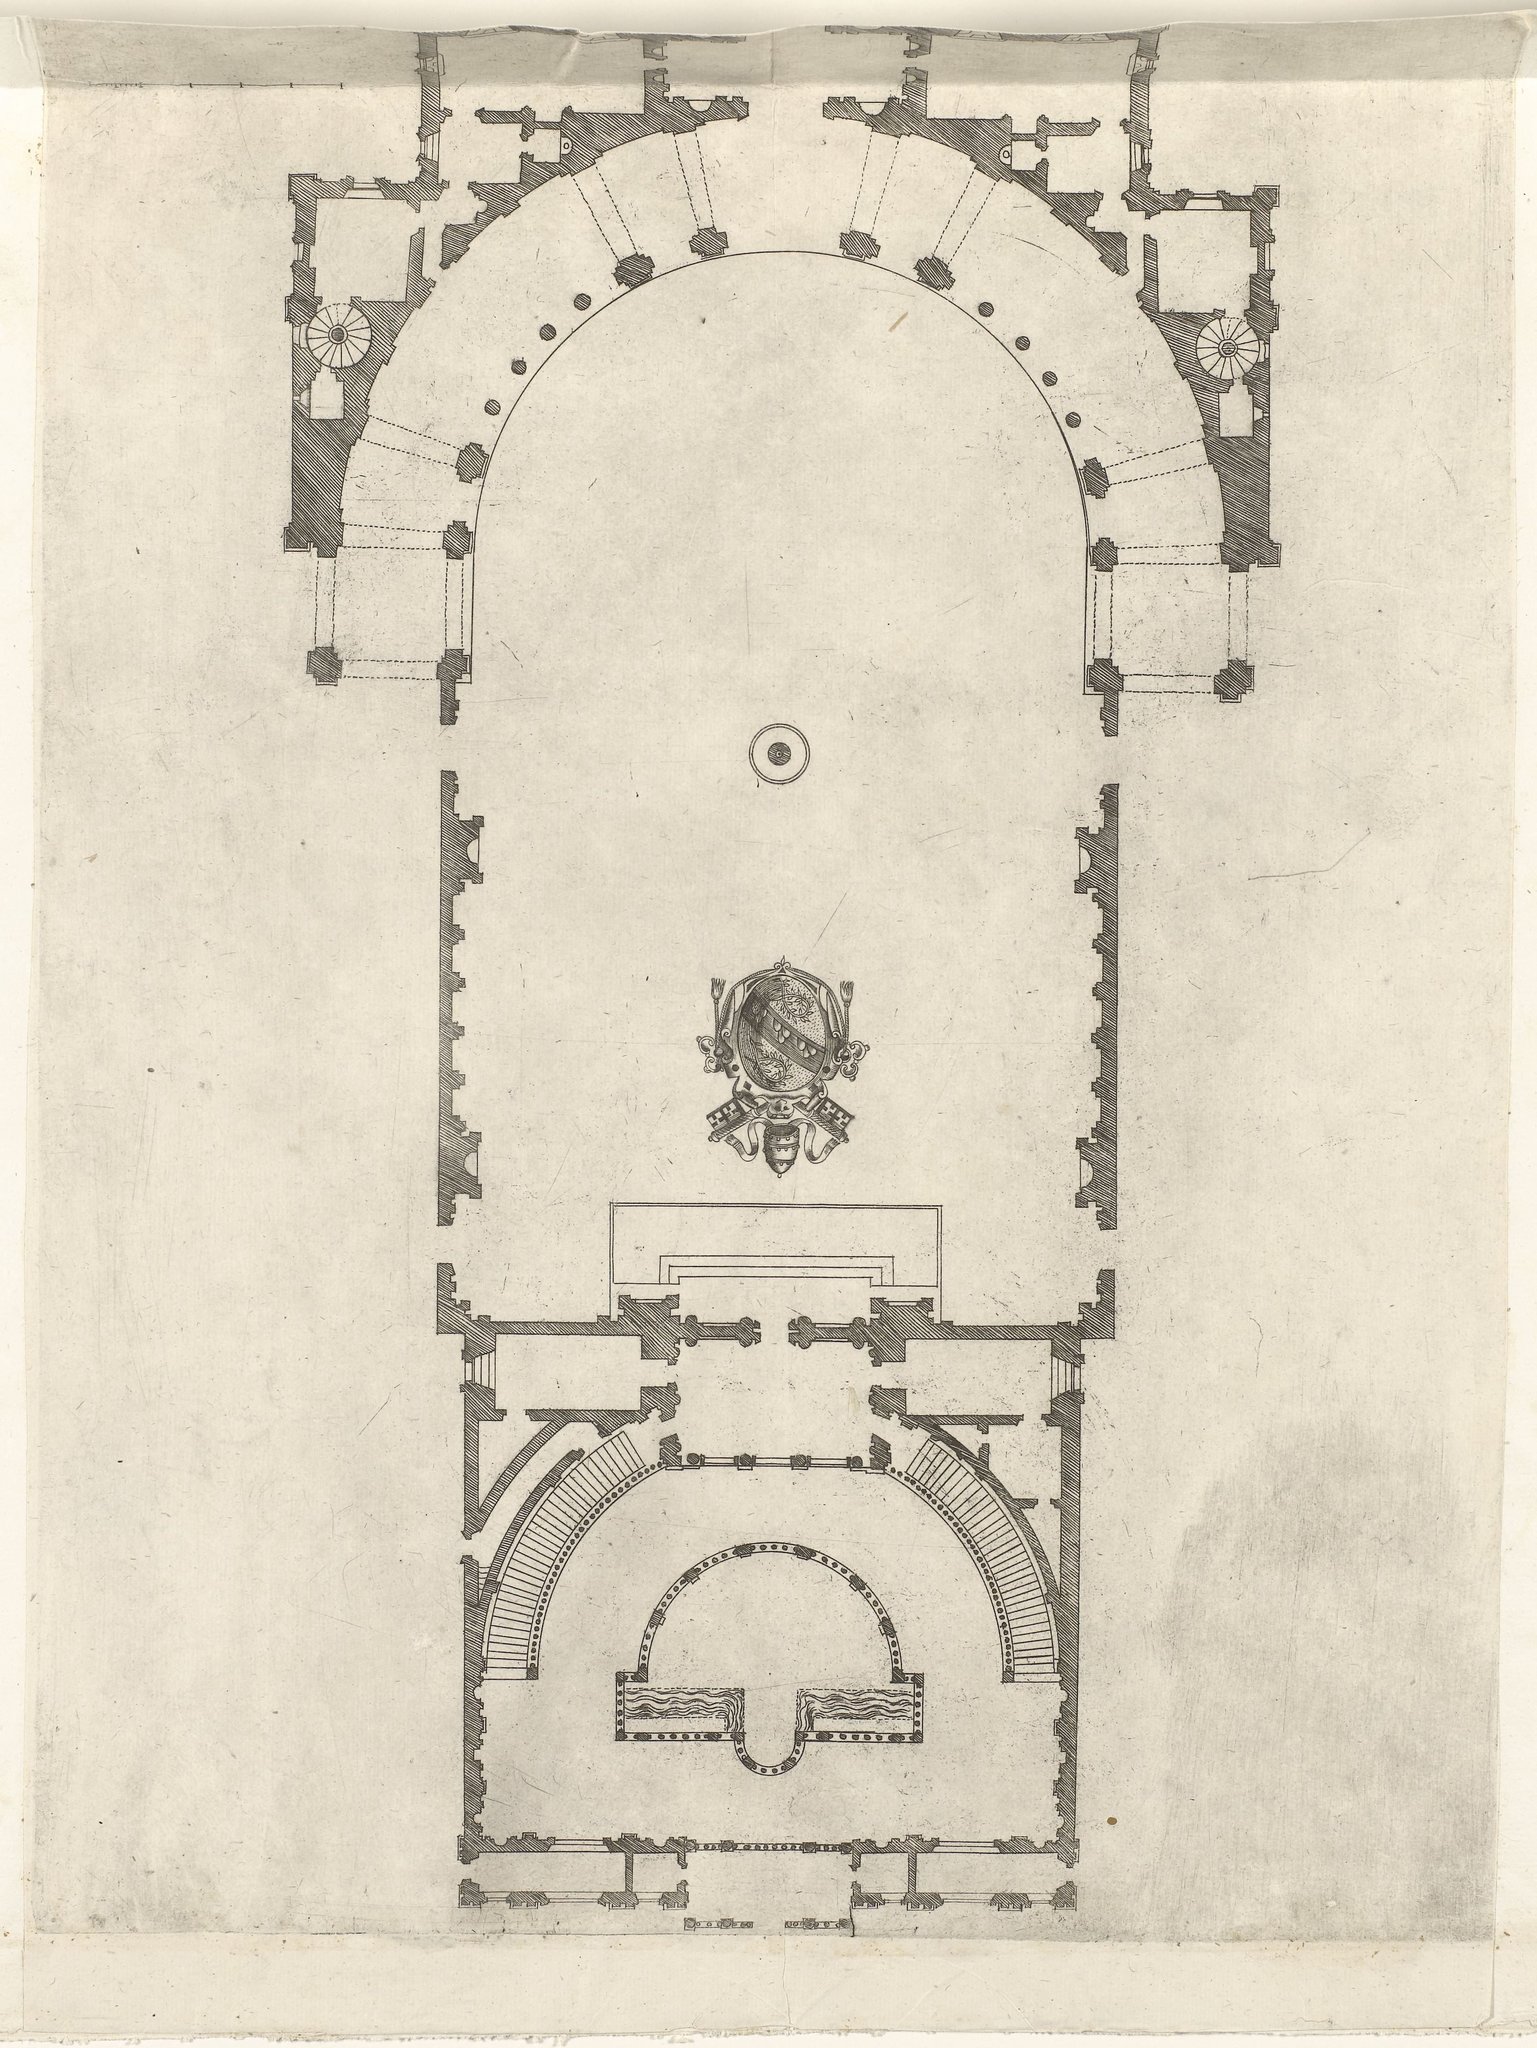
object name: print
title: Speculum Romanae Magnificentiae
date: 1560-1590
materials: paper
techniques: etching, intaglio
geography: rome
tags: ornamental fountain (in village), rome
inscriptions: collector's mark: Lugt 2228, collector's mark: Lugt 2760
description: Deze prent is geplakt op een oud albumblad. De prent wordt gerekend tot het supplement op het prentcorpus dat bekend staat als de ‘Speculum Romanae Magnificentiae’ (‘Spiegel van Romeinse pracht’). Dit corpus, bestaande uit prenten met voorstellingen van kunstwerken en gebouwen uit het antieke en het moderne Rome, vond zijn oorsprong bij uitgevers Antonio Salamanca en Antonio Lafreri. Deze twee buitenlandse uitgevers bundelden hun krachten te Rome in de periode 1553-1563. Hun prenten werden al snel razend populair bij toeristen en verzamelaars, die de prenten individueel of in grote groepen aanschaften. Grote groepen Speculum-prenten werden vaak op aanvraag samengebonden in albums. Er zijn verschillende Speculum-albums overgeleverd die allemaal verschillen van inhoud. Tussen 1573 en 1577 gaf Antonio Lafreri een speciale titelpagina uit (met de titel ‘Speculum Romanae Magnificentiae’) die mensen voor hun verzamelingen konden voegen. Het overlijden van Lafreri in 1577 betekende niet het einde van het corpus. Een groot deel van de koperplaten ging over op Claudio en Stefano Duchetti. De rest raakte verspreid over verschillende andere uitgevers. De populariteit van de Speculum-prenten wist nog geruime periode uitgevers te inspireren tot het laten maken van kopieën en het toevoegen van nieuwe prenten aan het corpus.